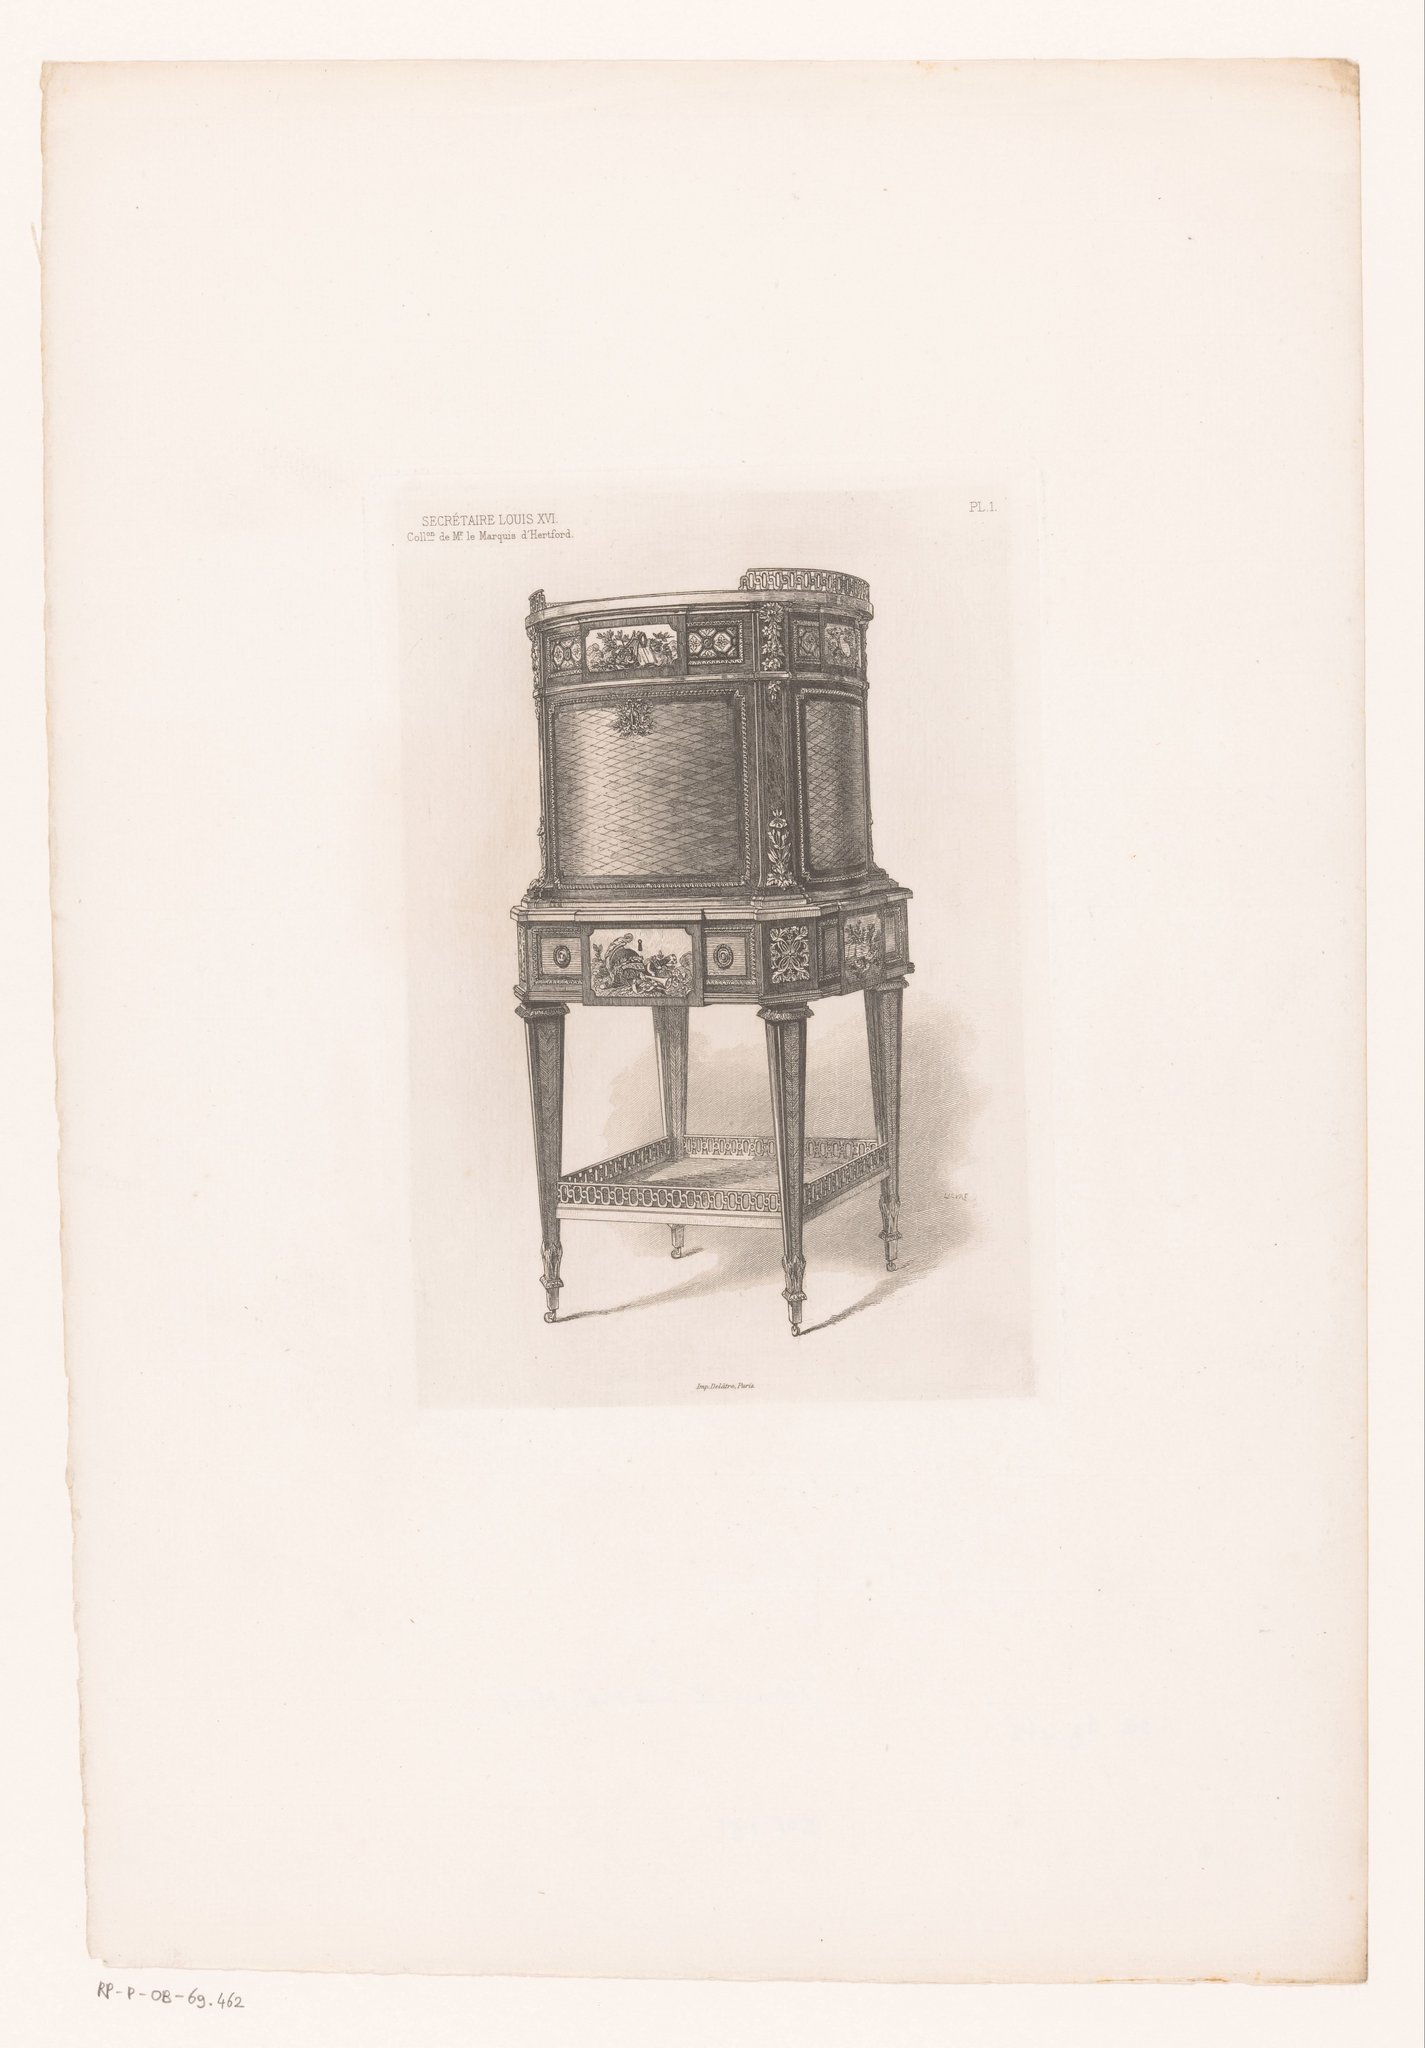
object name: print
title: Secretaire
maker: edouard lièvre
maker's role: print maker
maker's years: 1829-1886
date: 1866-1879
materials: paper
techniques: etching, intaglio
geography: paris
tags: writing-table, writing-desk, secretary, scribe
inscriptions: collector's mark: Lugt 2228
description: Prent uit: Firmin-Didot, Ambroise. Les collections célèbres d'oeuvres d'art dessinées et gravées d'après les originaux par Edouard Lièvre. Parijs: Goupil & Cie, 1866-1879.